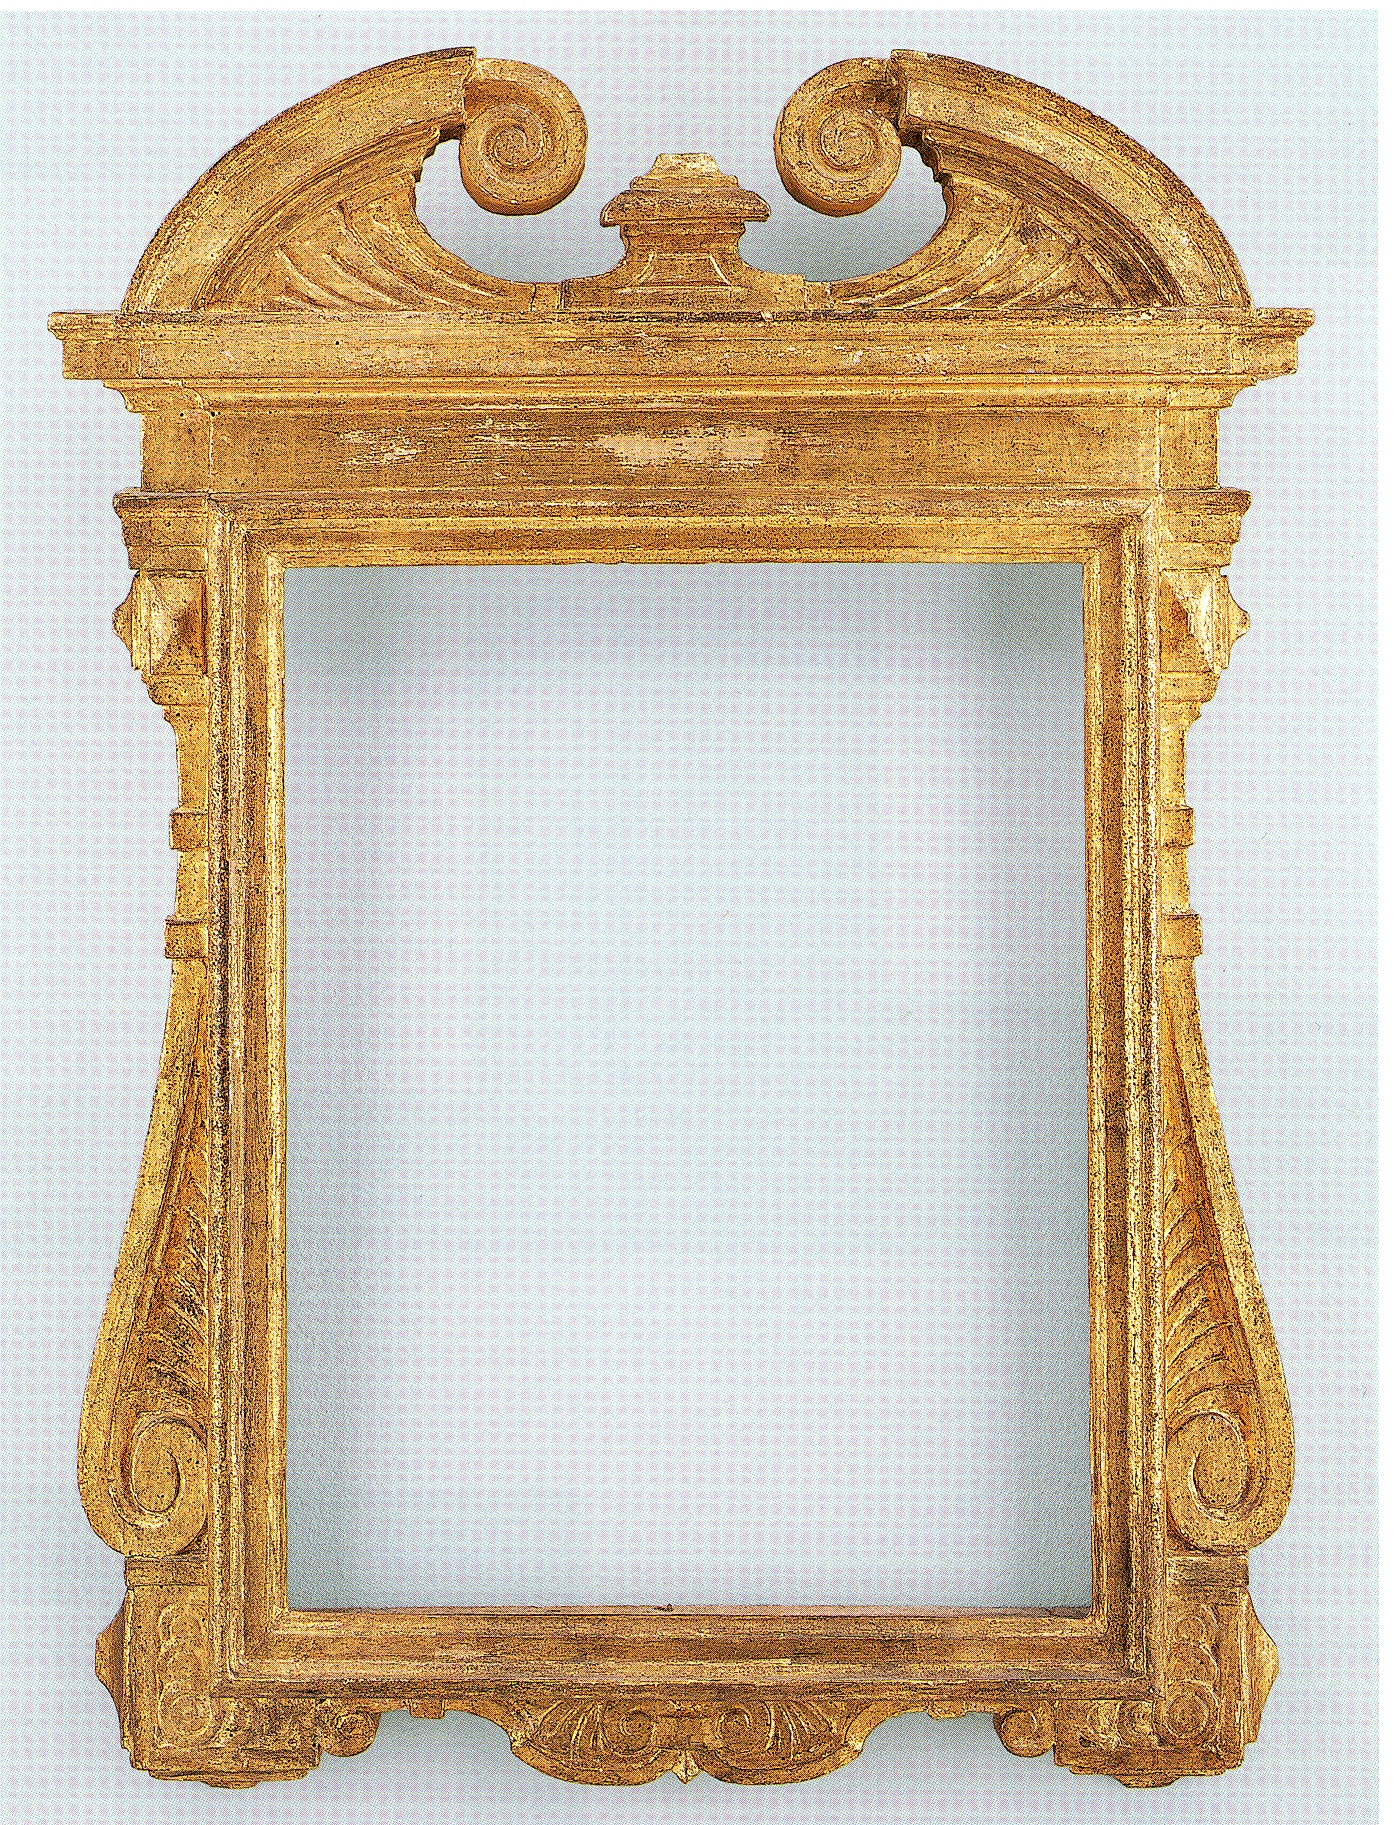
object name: frame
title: Tabernacle frame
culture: italian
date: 1640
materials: wood